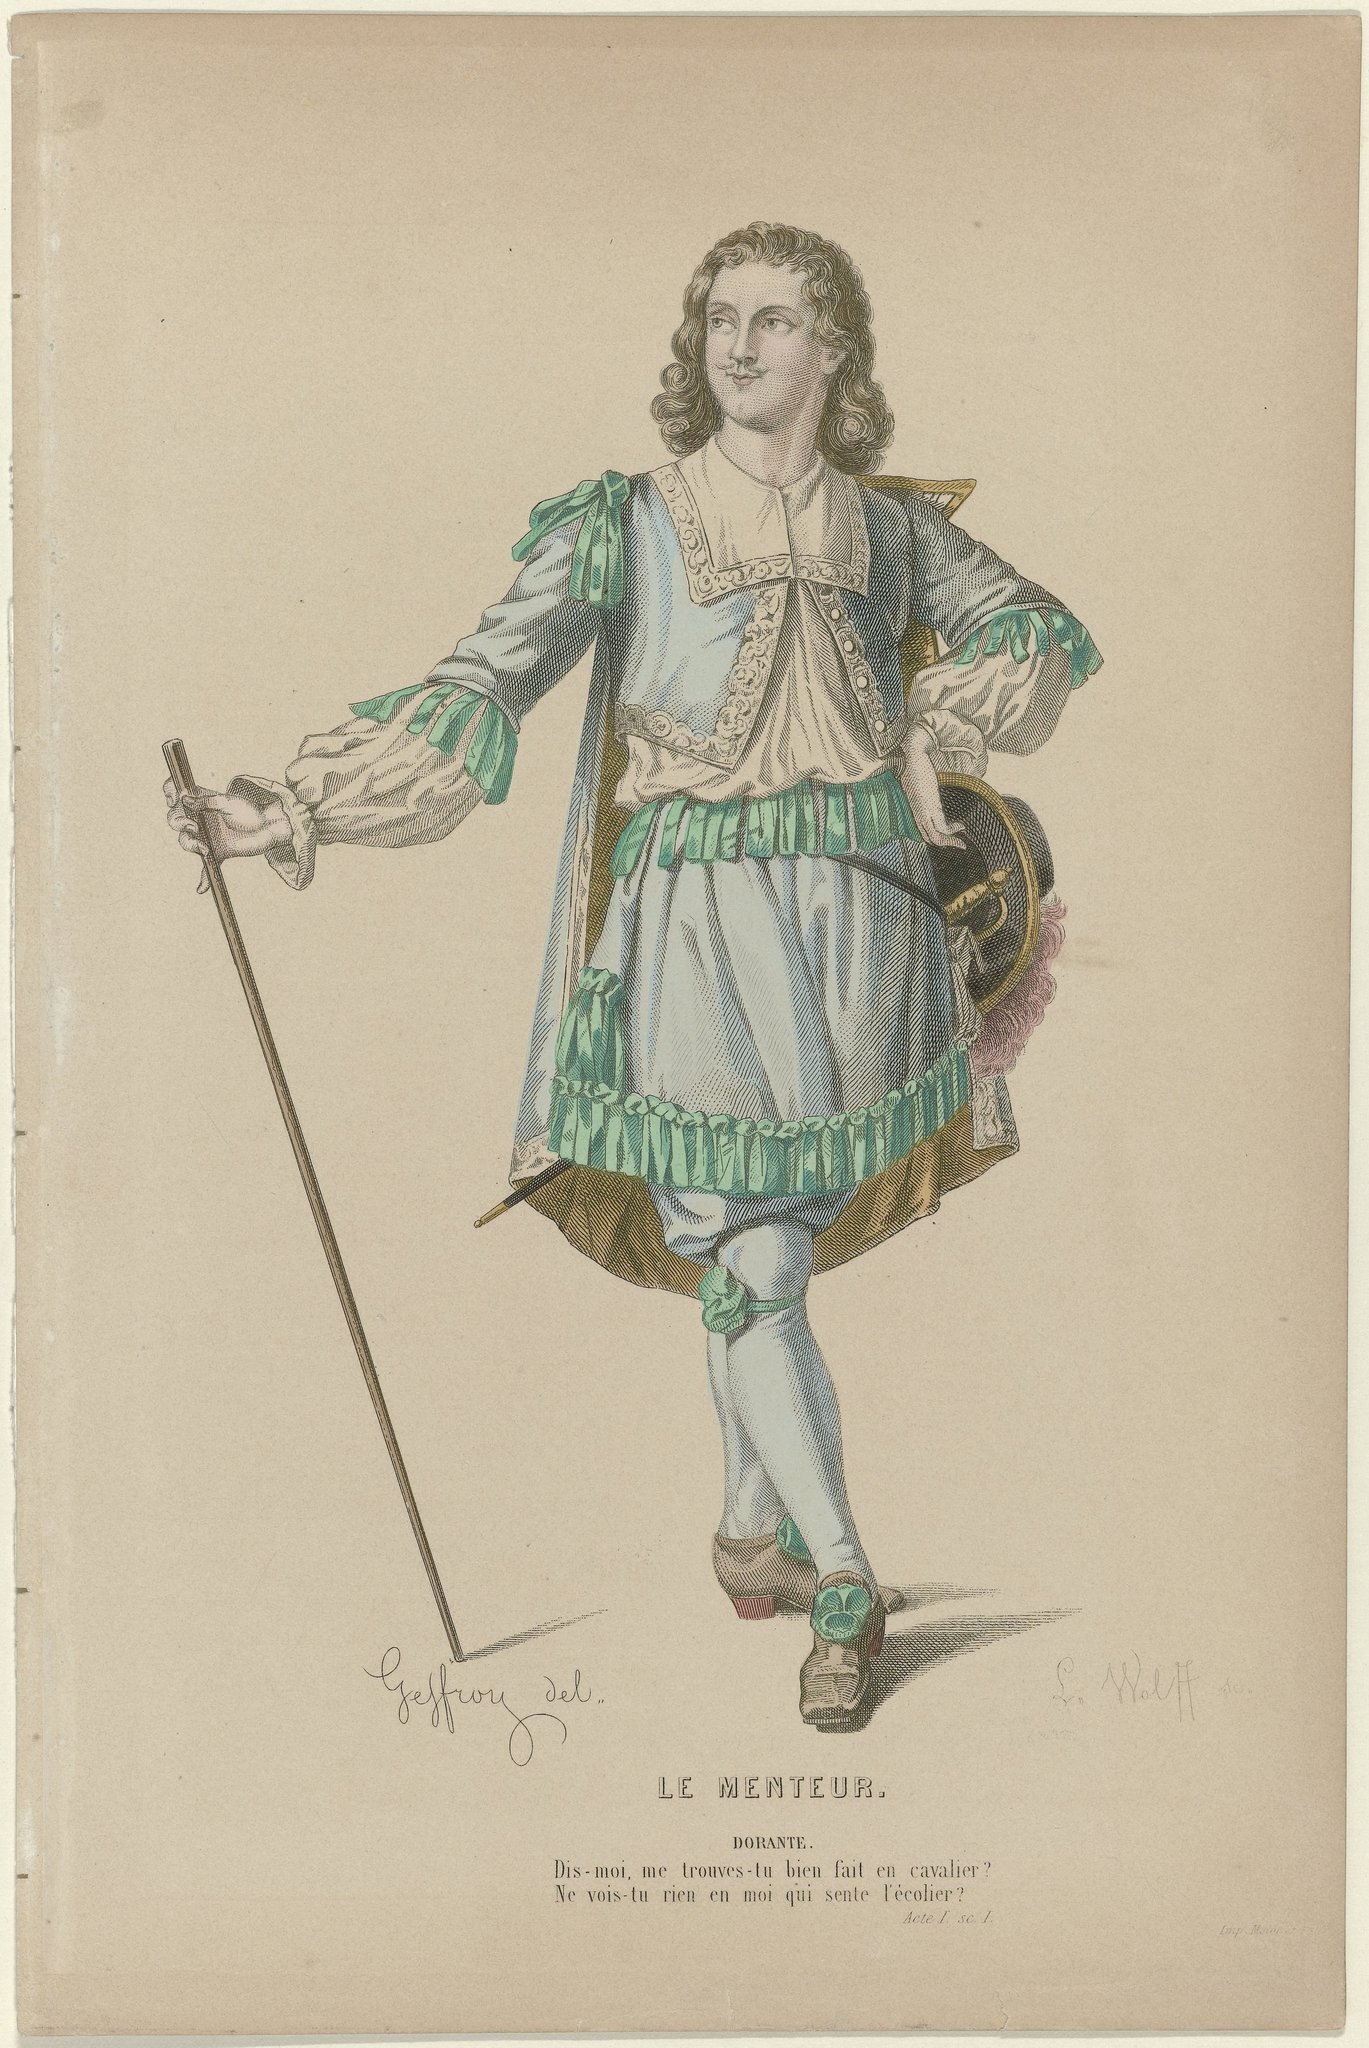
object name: fashion print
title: Le Menteur, 1852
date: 1852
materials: paper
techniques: hand coloring, engraving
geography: paris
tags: hacking and thrusting weapons, coat (+ men's clothes), head-gear: hat (+ men's clothes), fashion plates, shoes, sandals (+ men's clothes), clothing for the upper part of the body (+ men's clothes), actor (on the stage), walking-stick, staff, cane (+ men's clothes)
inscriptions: title: ‘Le Menteur’, caption: ‘Dorante. Dis-moi, me trouves-tu bien fait en cavalier? / Ne vois-tu rien en moi qui sente l'écolier? / Acte I.sc. I.’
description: Theaterkostuum voor de rol van Dorante als Cavalier in de komedie 'Le Menteur' (de leugenaar), geschreven door Pierre Corneille in 1643. Cape, gepluimde hoed, wandelstok en degen. Twee regels tekst uit de eerste akte, scéne één.